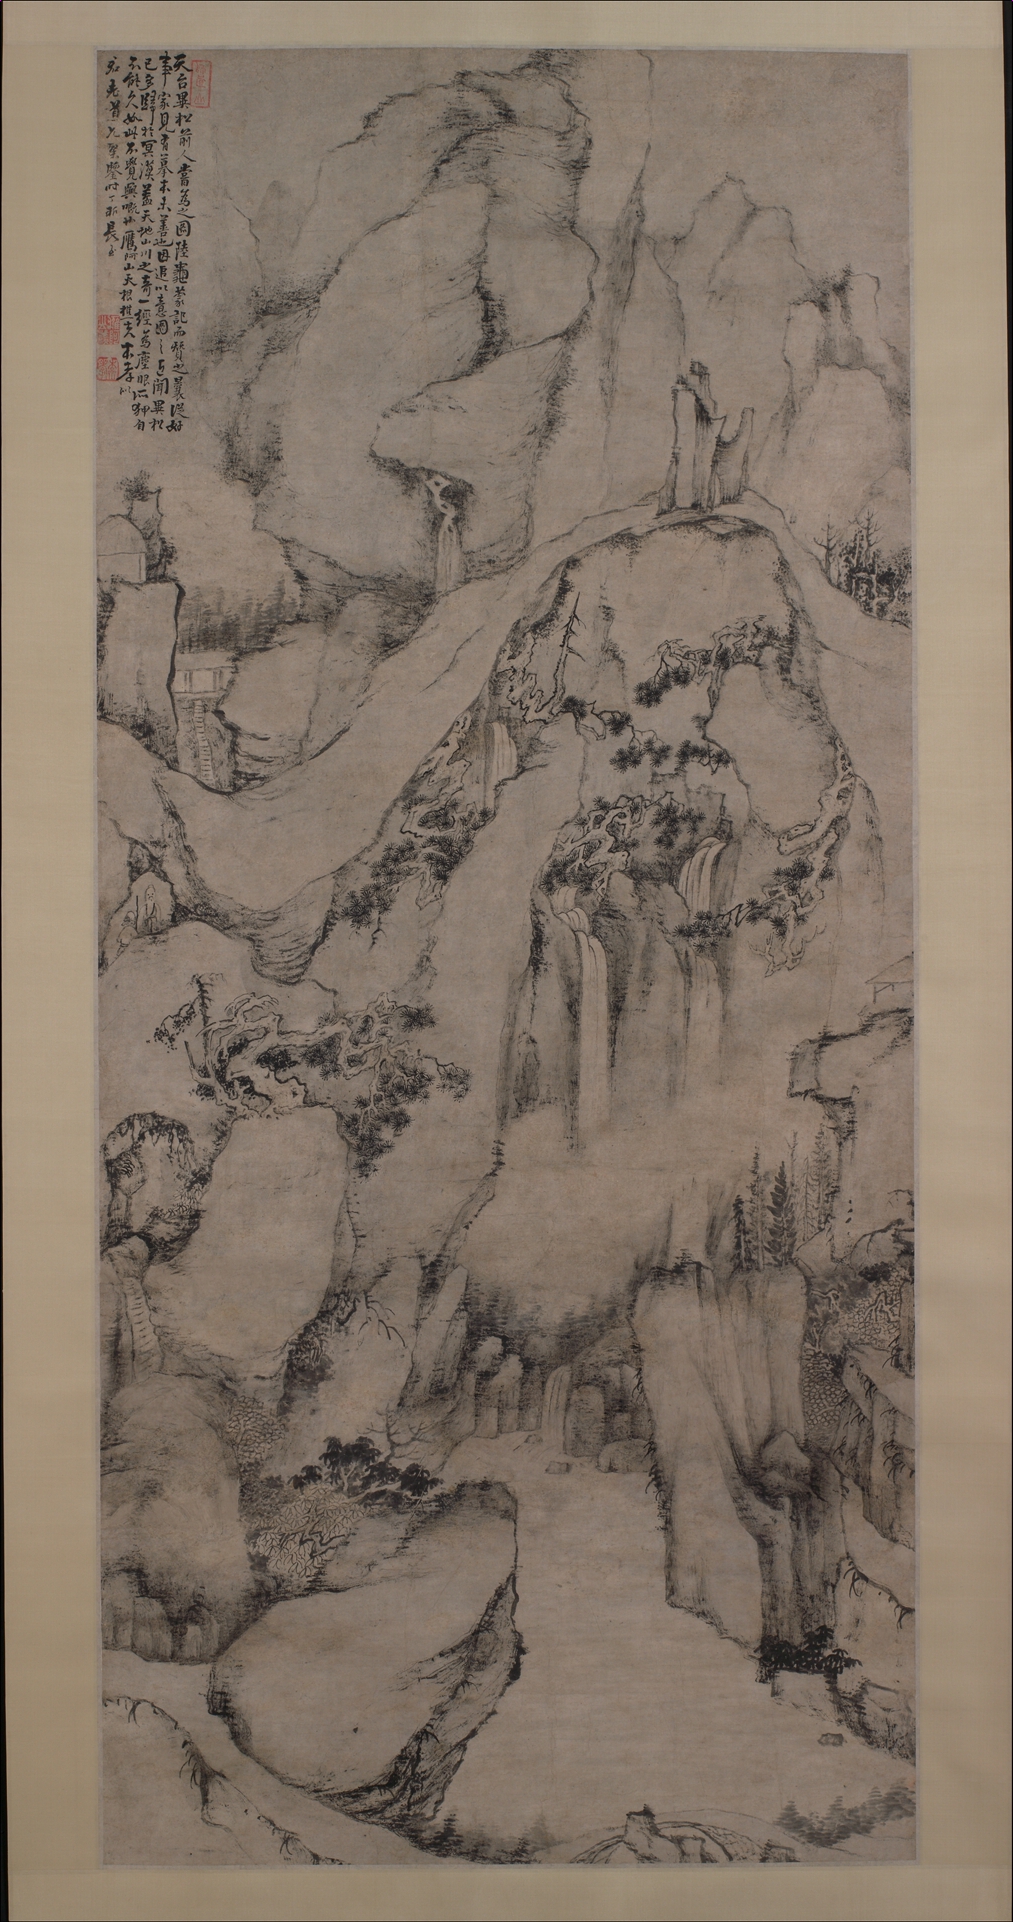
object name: hanging scroll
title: The Strange Pines of Mount Tiantai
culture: chinese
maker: dai benxiao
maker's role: artist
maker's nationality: chinese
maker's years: 1621-1693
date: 1687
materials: ink, paper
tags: mountains